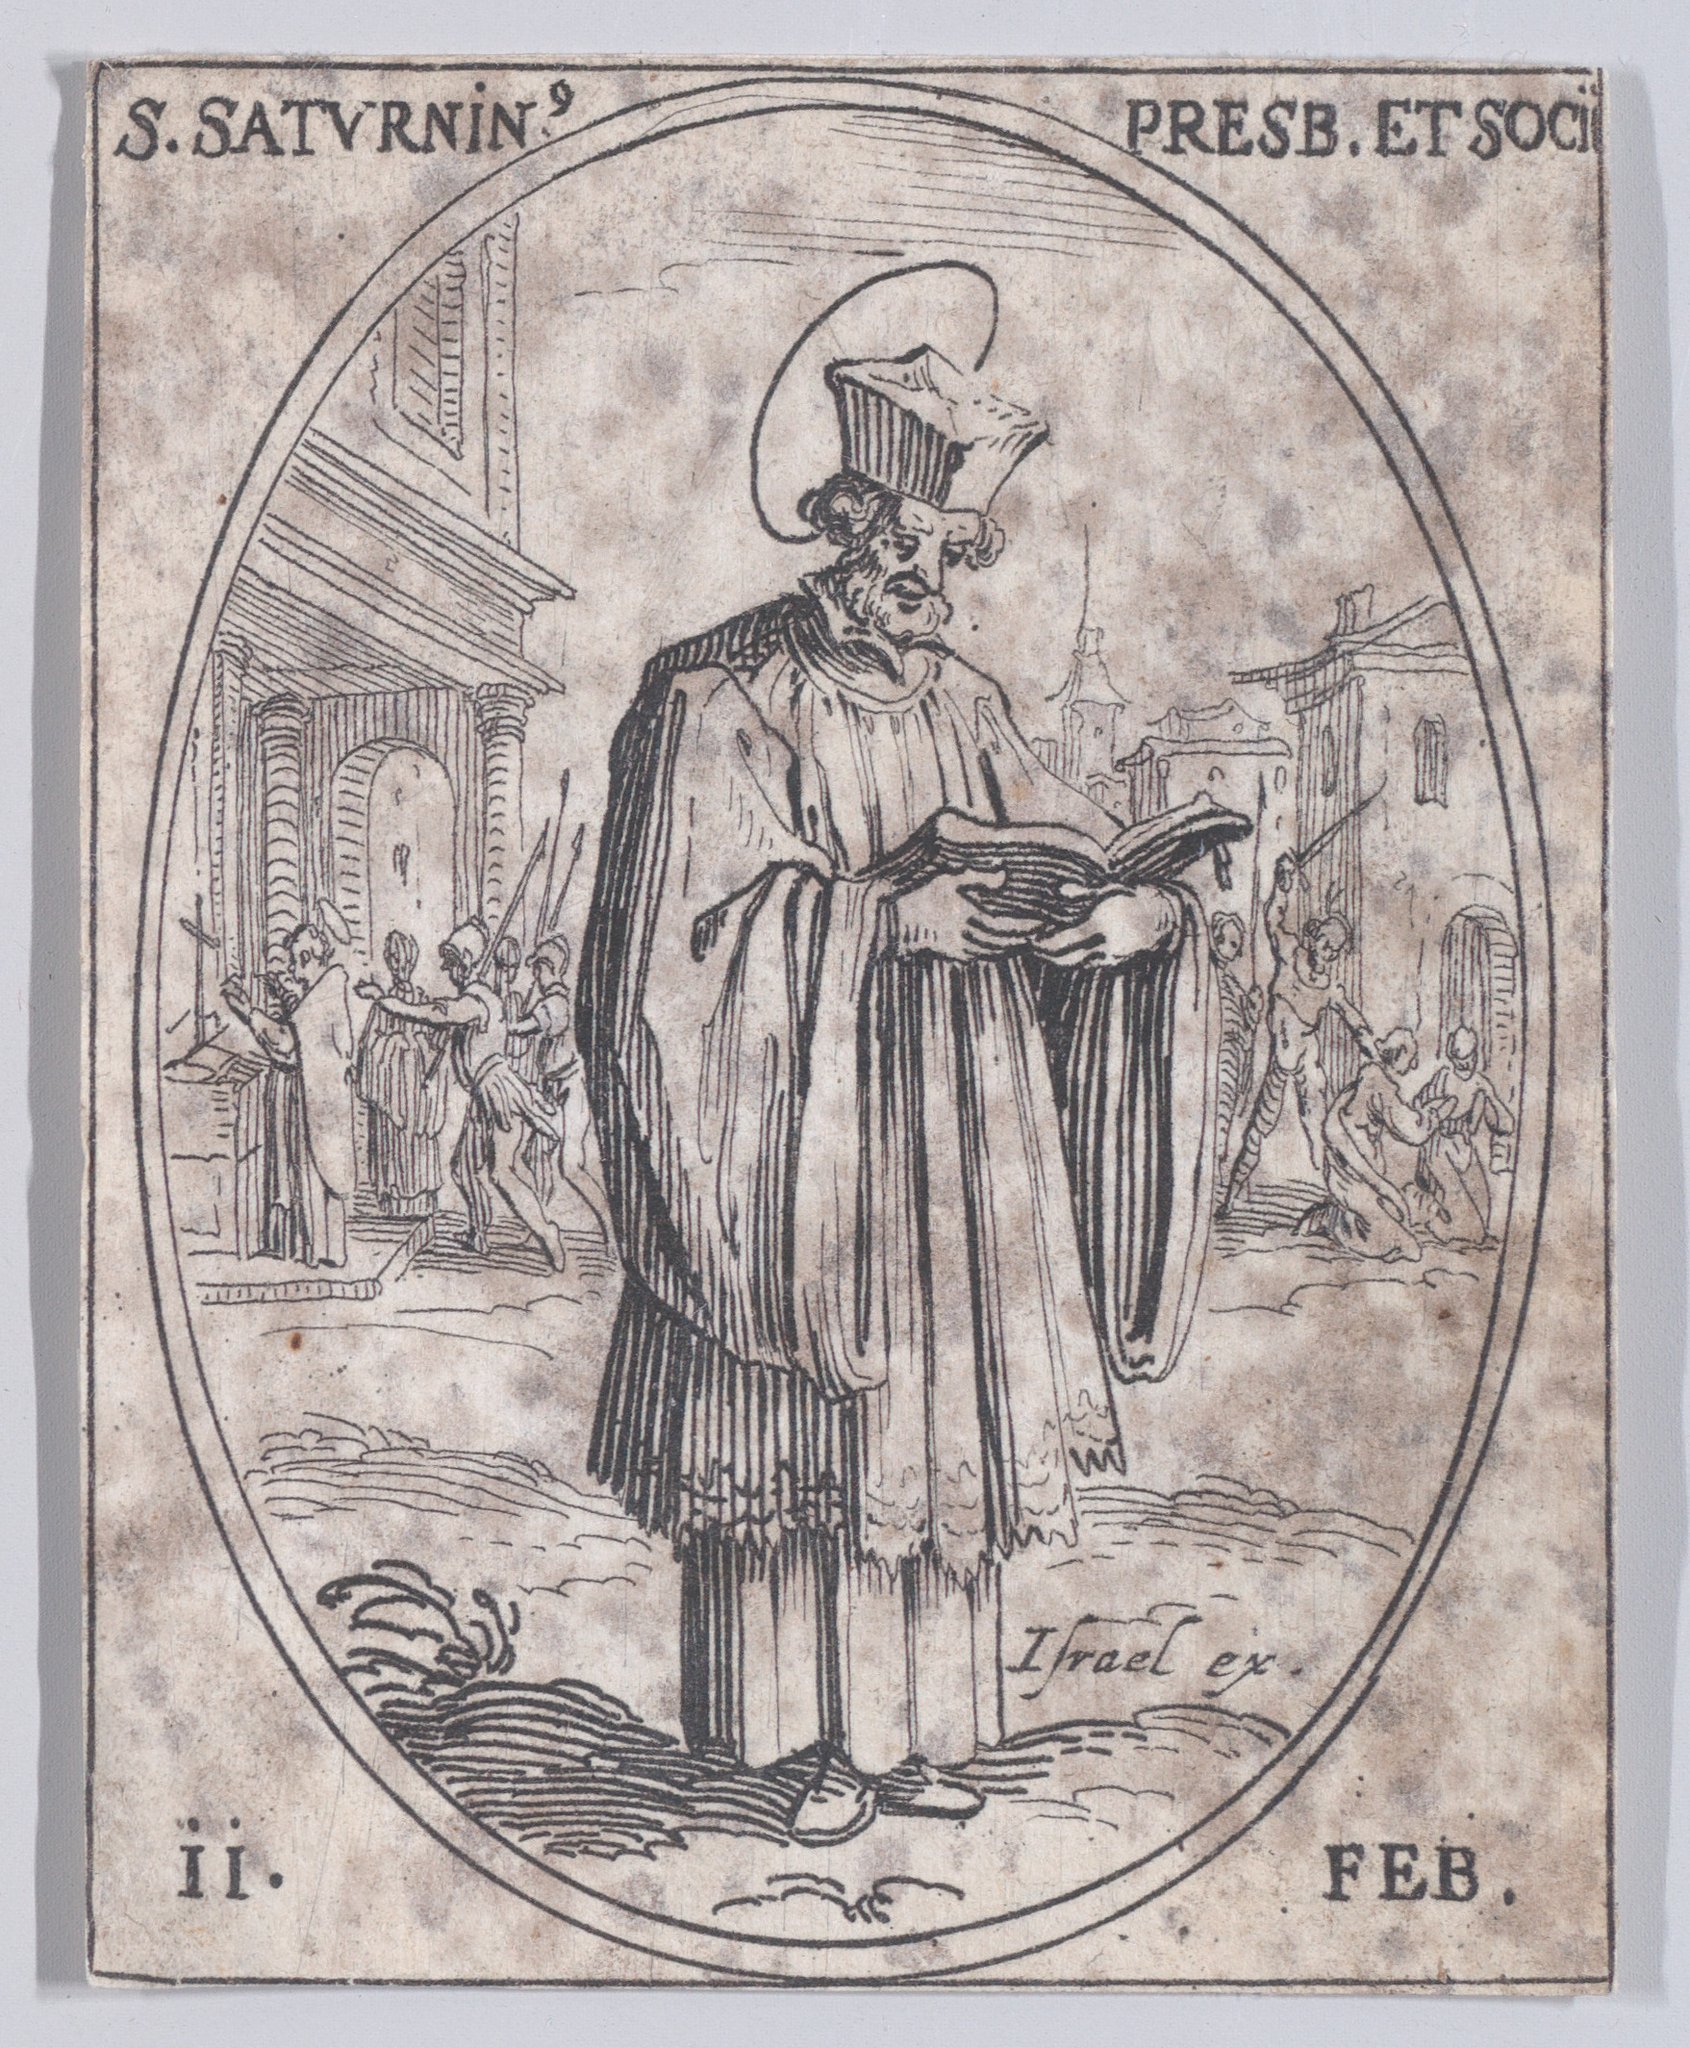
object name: print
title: S. Saturnin, prêtre et ses compagnons (St. Saturninus, Priest and His Companions), February 11th, from "Les Images De Tous Les Saincts et Saintes de L'Année" (Images of All of the Saints and Religious Events of the Year)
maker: jacques callot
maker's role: artist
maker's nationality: french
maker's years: 1592-1635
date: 1636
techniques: etching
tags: men,saints